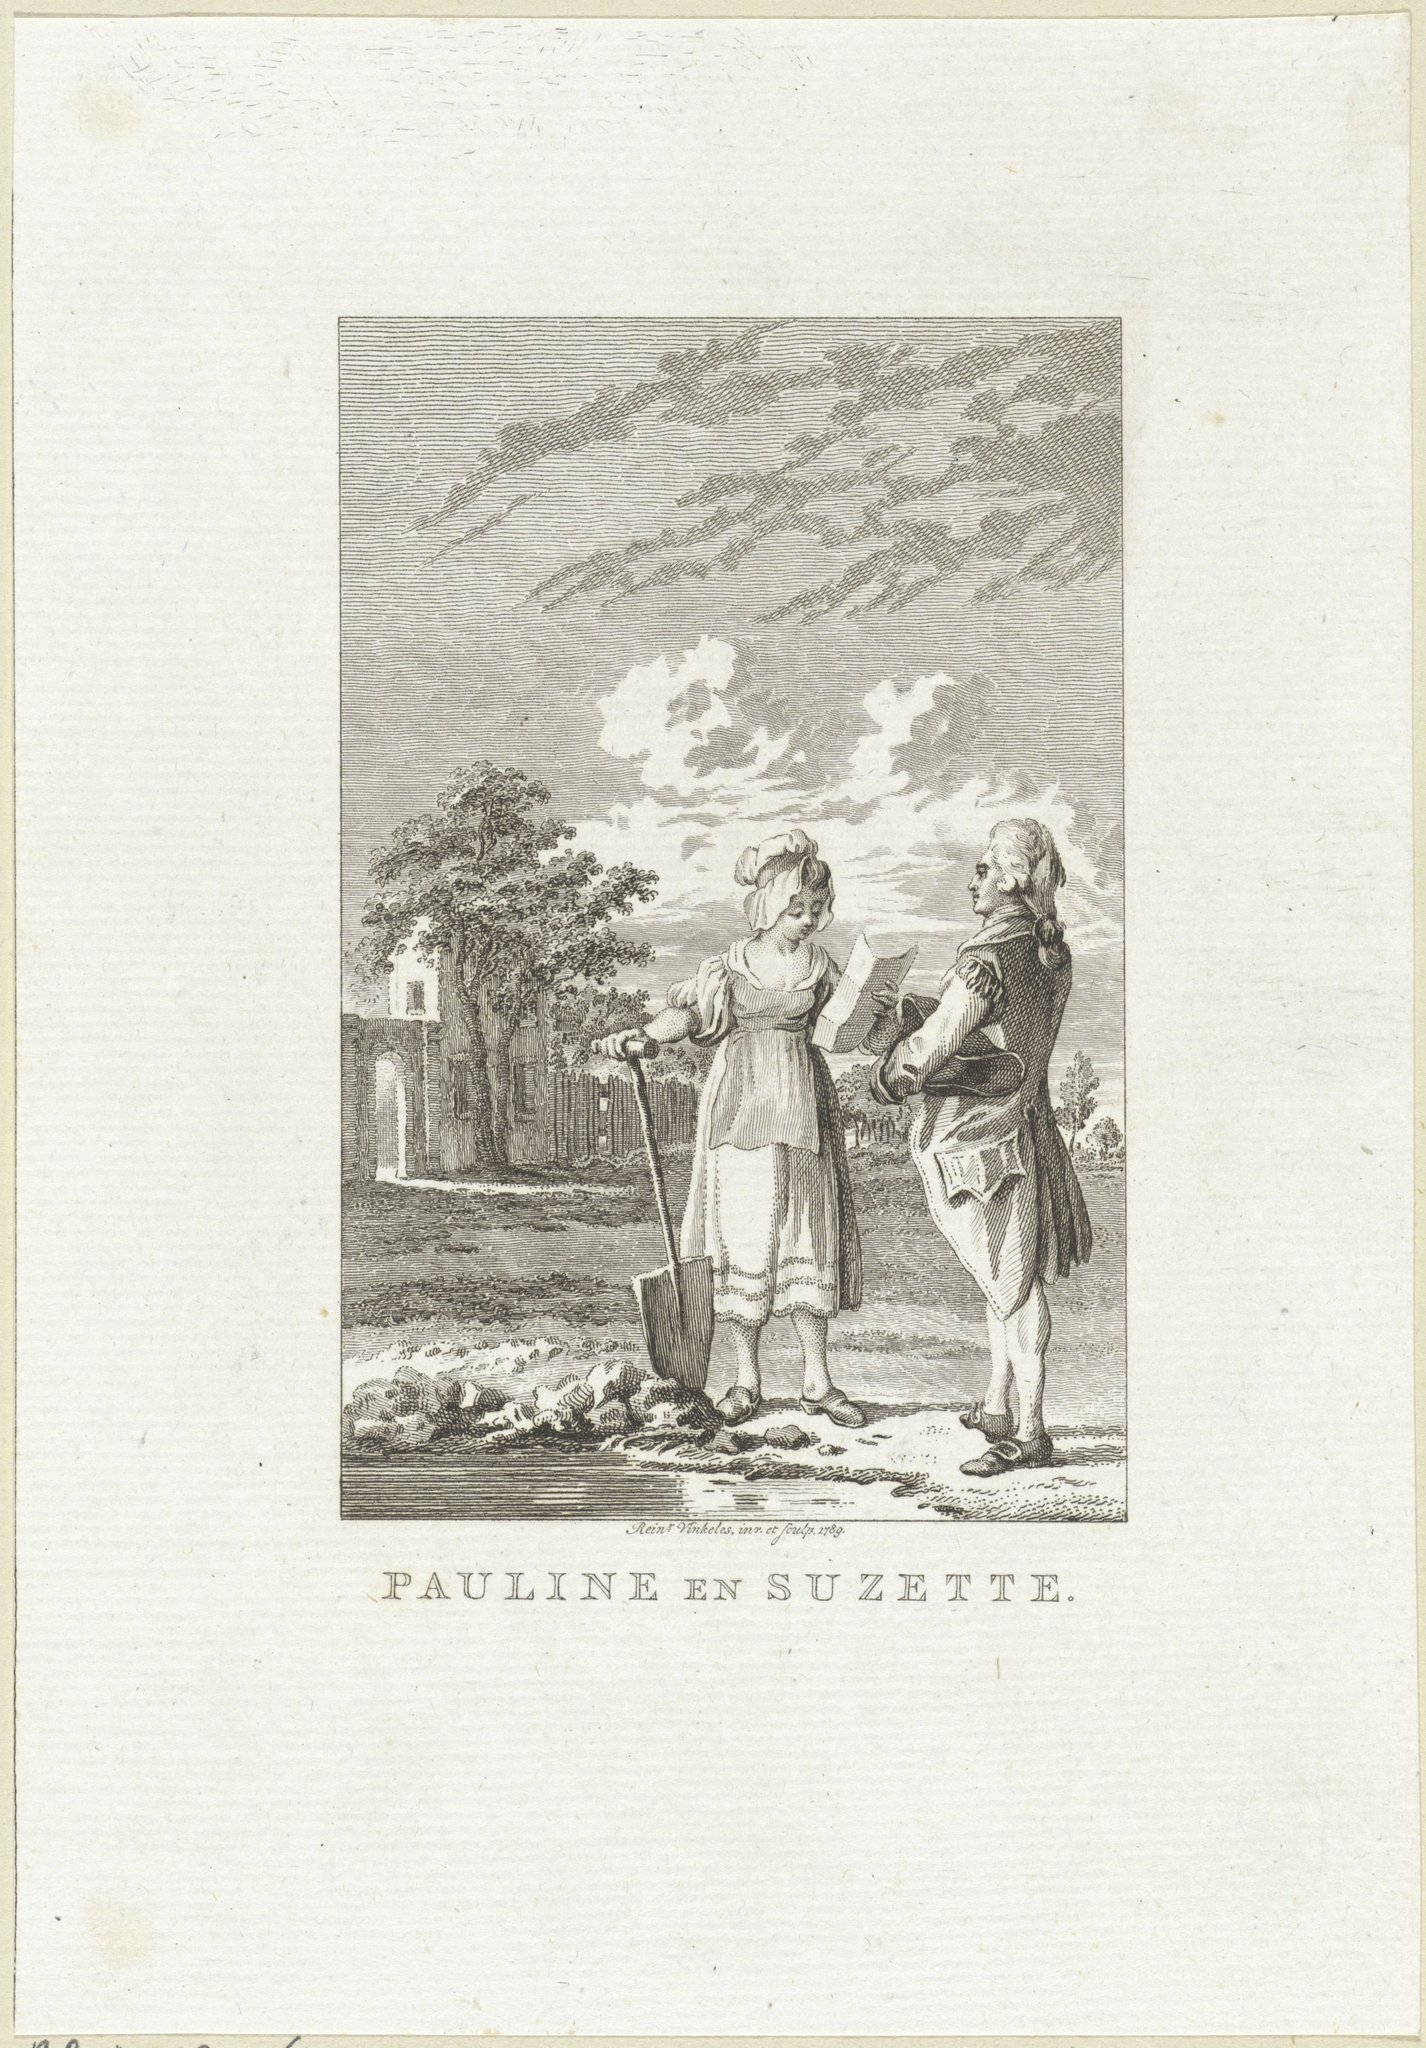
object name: print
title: Vrouw met een schep en een brief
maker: reinier vinkeles (i)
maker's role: draughtsman, print maker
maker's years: 1741-1816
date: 1789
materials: paper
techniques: engraving, etching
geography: amsterdam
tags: reading, landscapes, agricultural implements: spade, letter, envelope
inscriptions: collector's mark: Lugt 240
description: Deze prent is ook gebruikt als illustratie bij het verhaal 'Pauline en Suzette' voor: Baculard d'Arnaud, F.T.M. de. Zedelijke verhaalen, deel 12. Amsterdam: A. Mens Jansz., 1789.